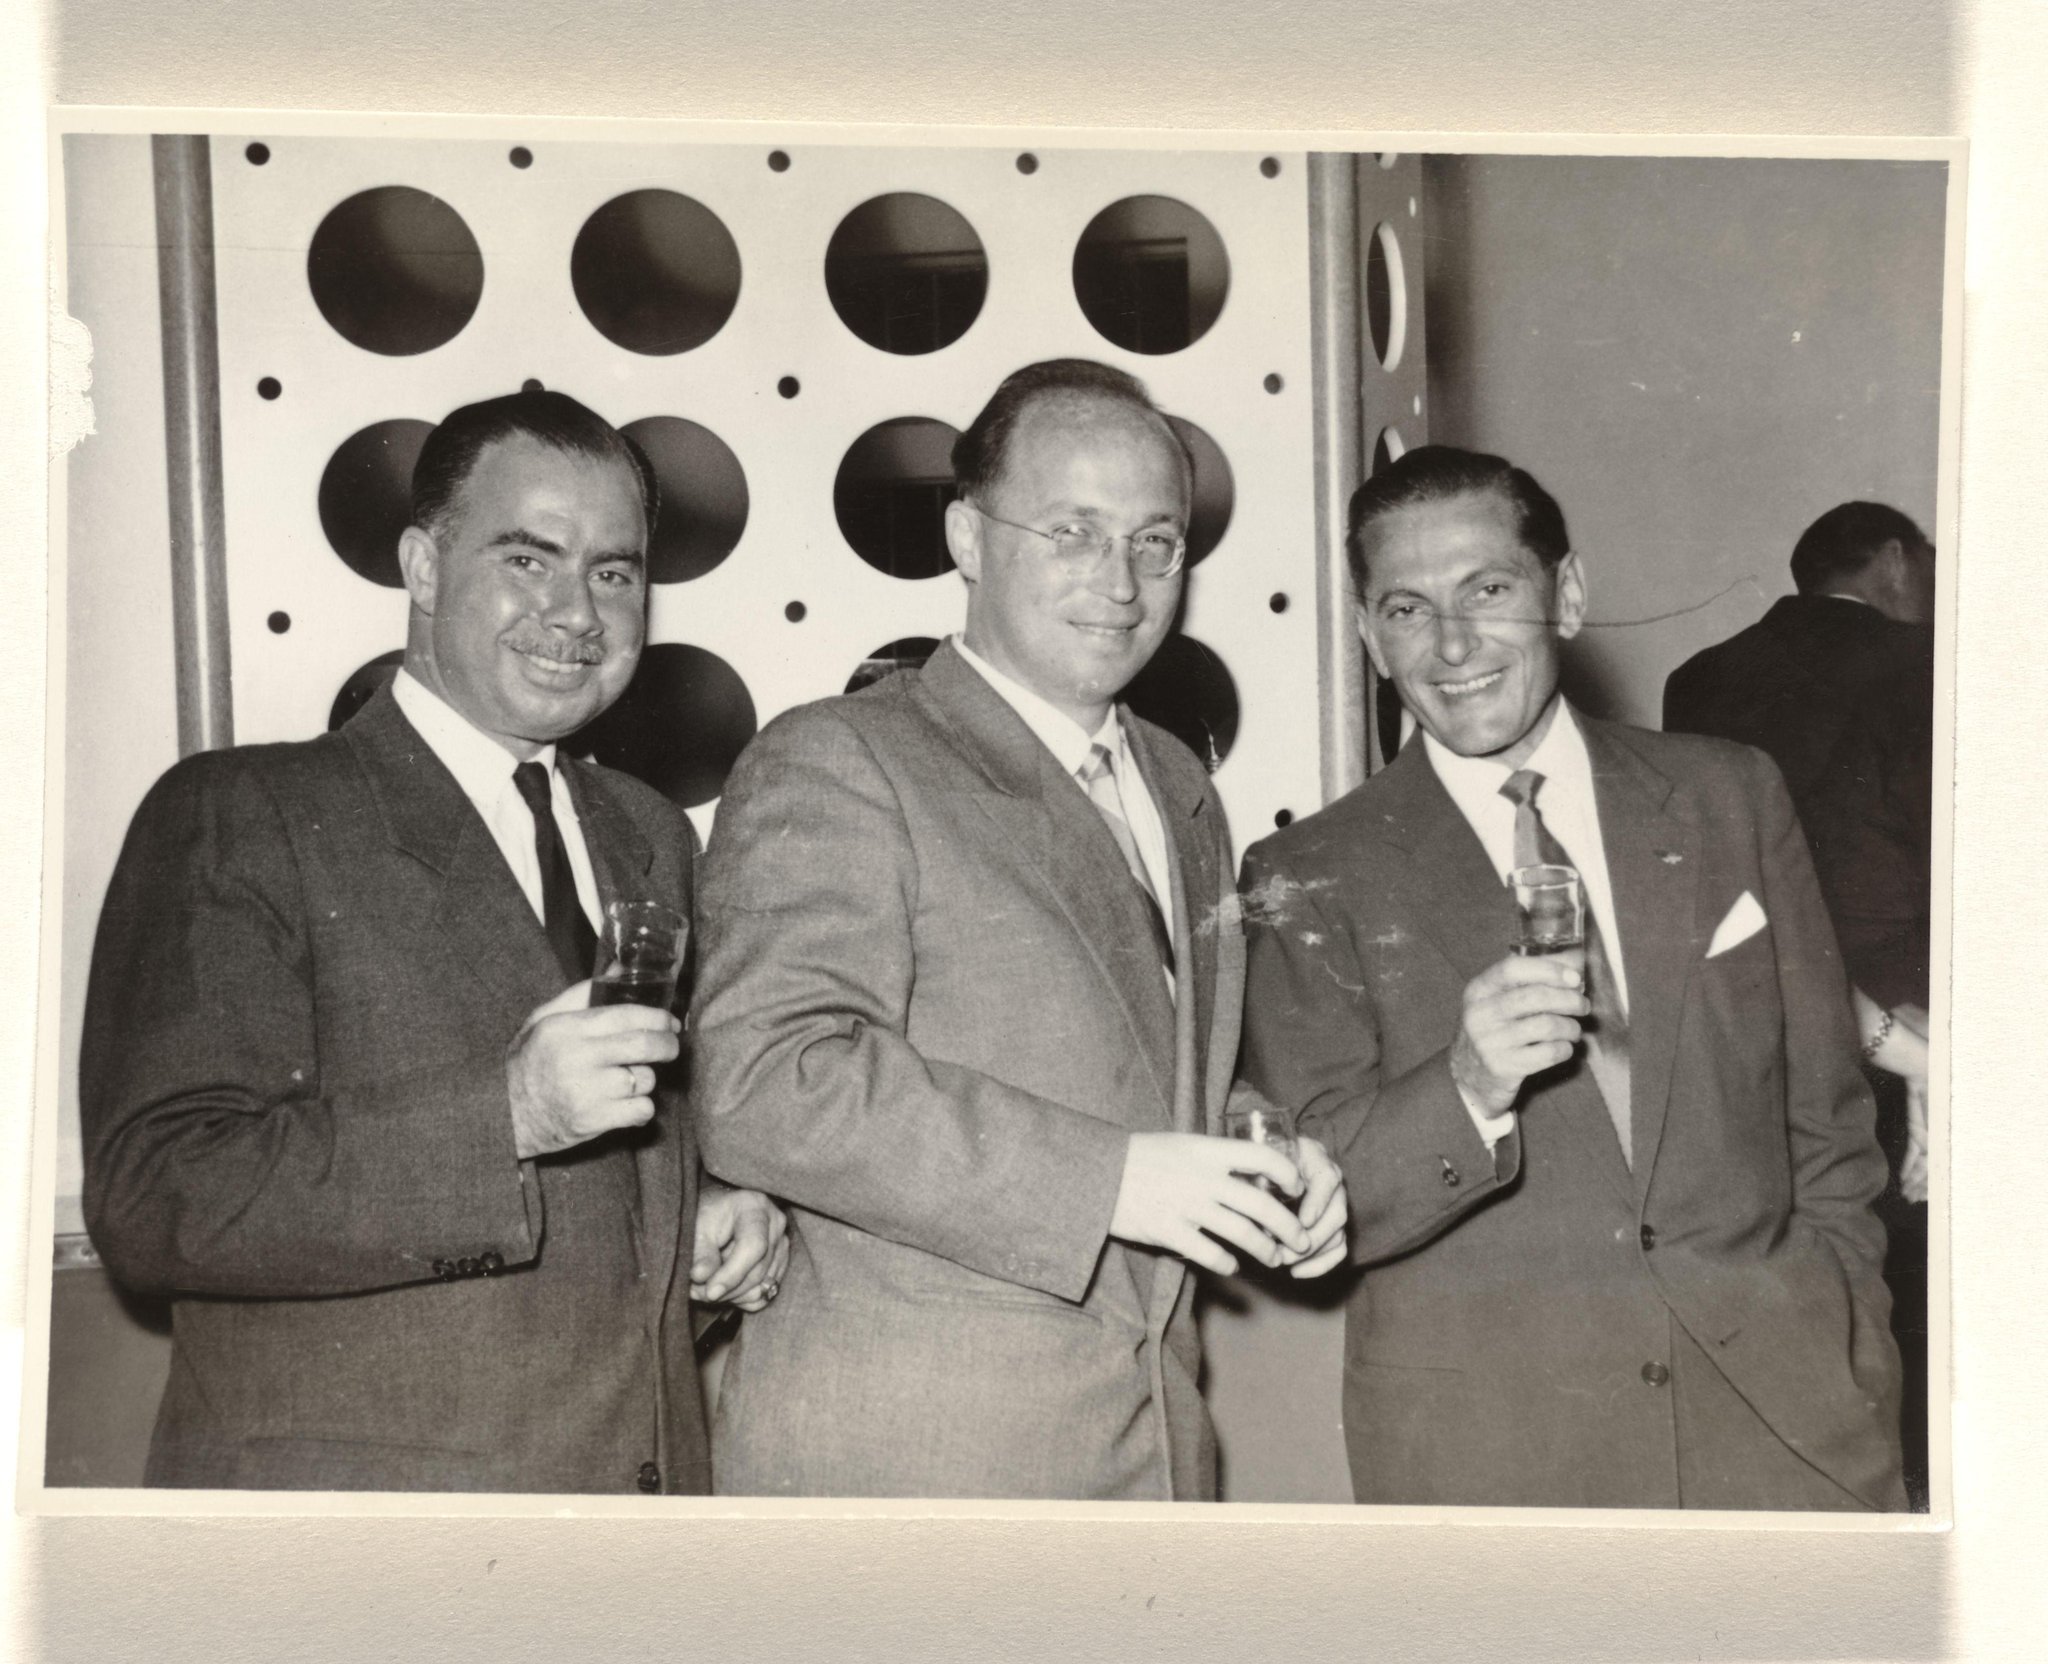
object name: photograph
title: Gideon Elon met twee onbekende mannen, tijdens een receptie gedurende de KLM-tijd van Isabel Wachenheimer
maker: Anonymous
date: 1956-1973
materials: photographic support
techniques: gelatin silver print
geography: israel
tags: gideon elon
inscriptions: number: ‘2134/41a’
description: Gideon Elon (rechts) in gesprek met twee onbekende mannen, tijdens een receptie.